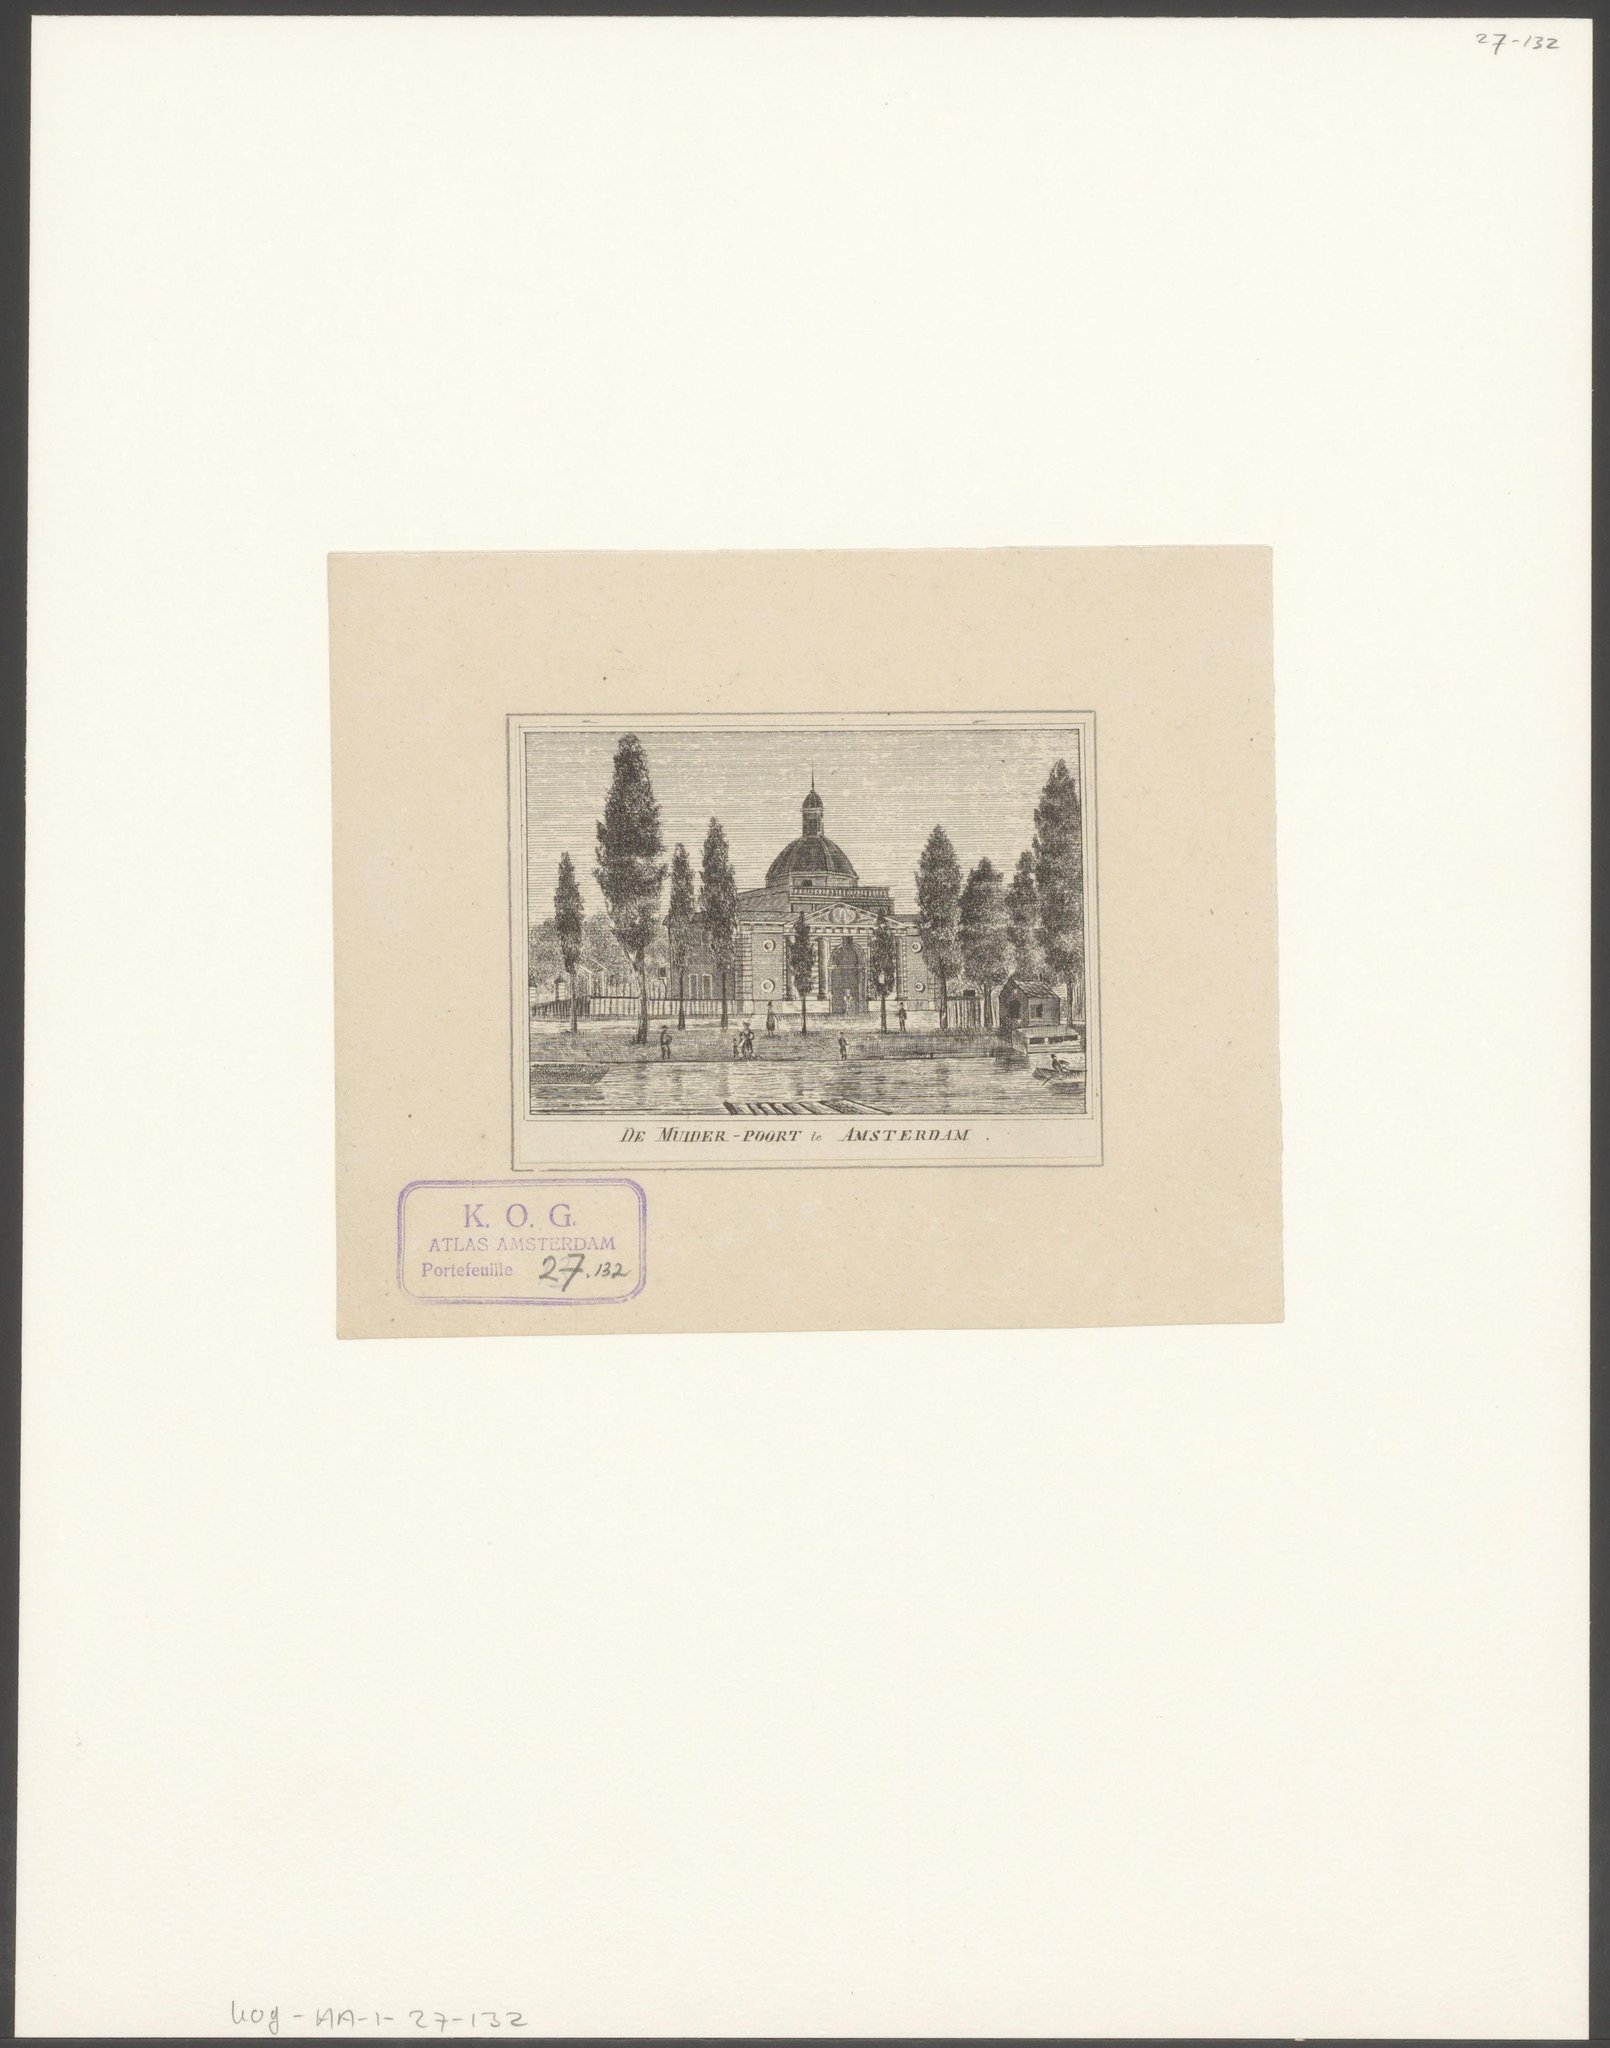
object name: print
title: Gezicht op de Tweede Muiderpoort te Amsterdam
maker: Anonymous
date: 1700-1799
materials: paper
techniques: engraving, etching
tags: road, path, city-gate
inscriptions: collector's mark: Lugt 1641b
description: Onderwerpsrubriek binnen de Atlas Amsterdam: Poorten, verzamelbladen, J. Tweede Muiderpoort.